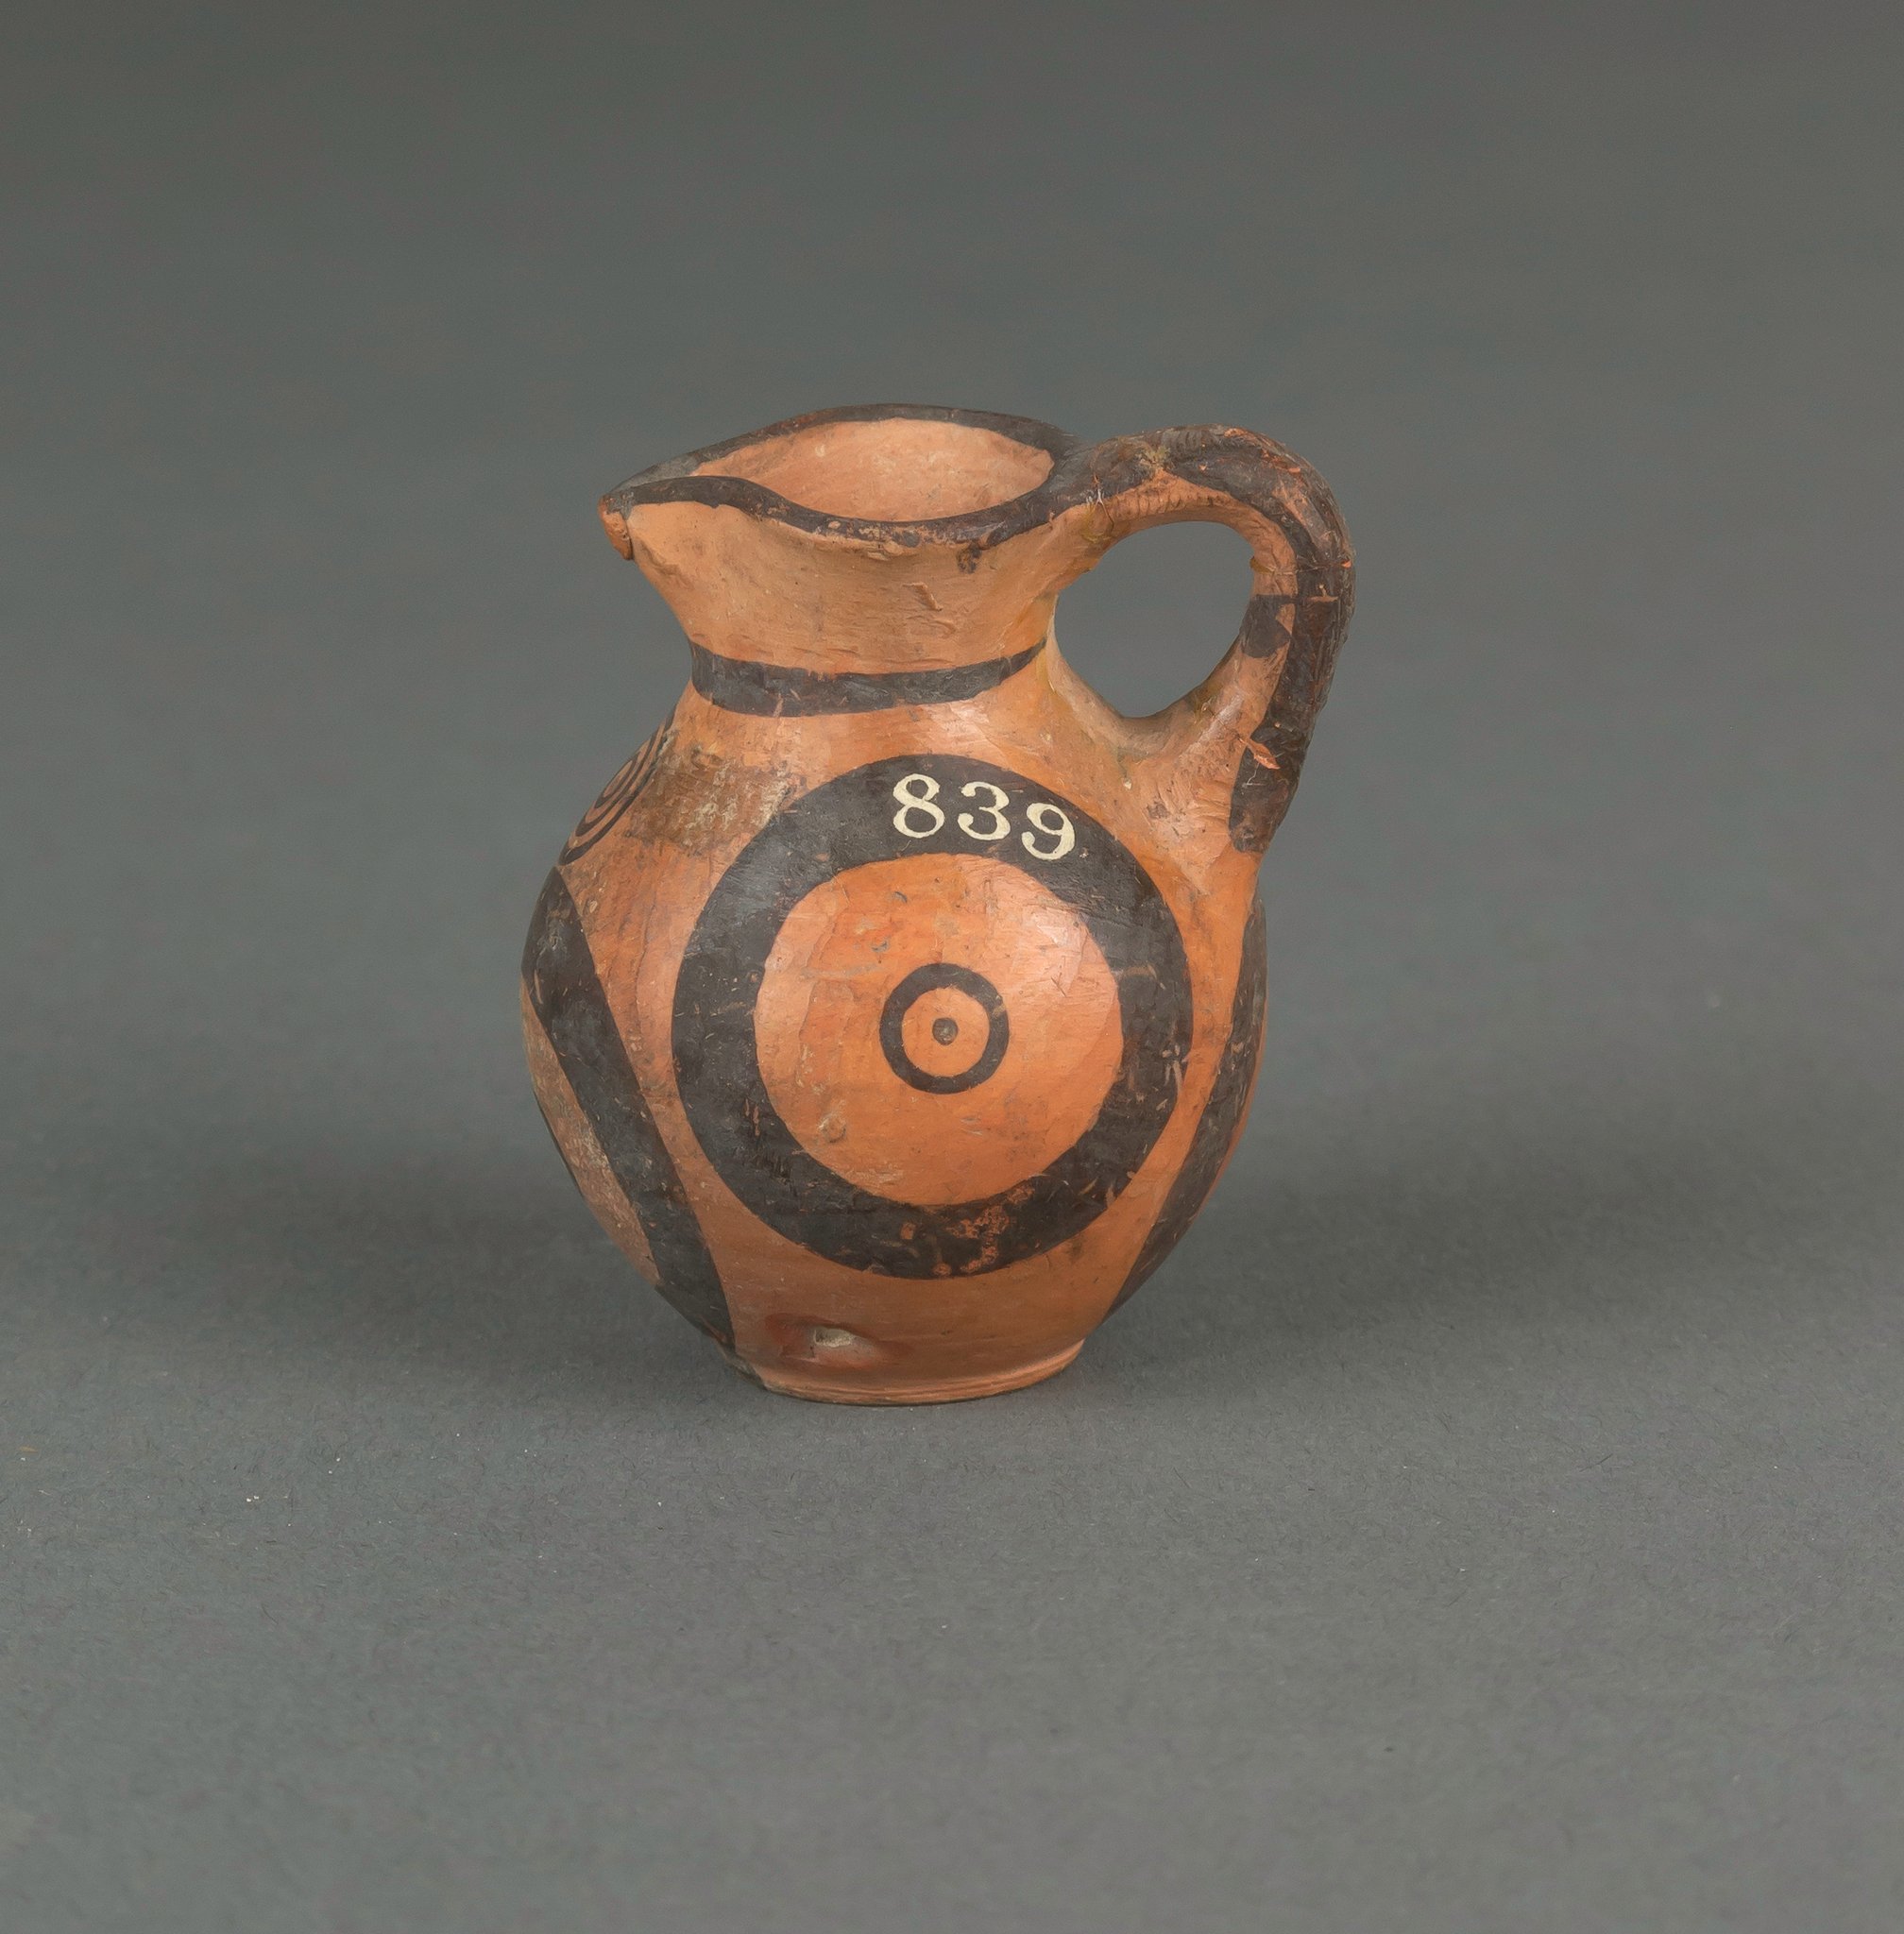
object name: oinochoe, miniature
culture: cypriot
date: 850-750 BCE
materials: terracotta